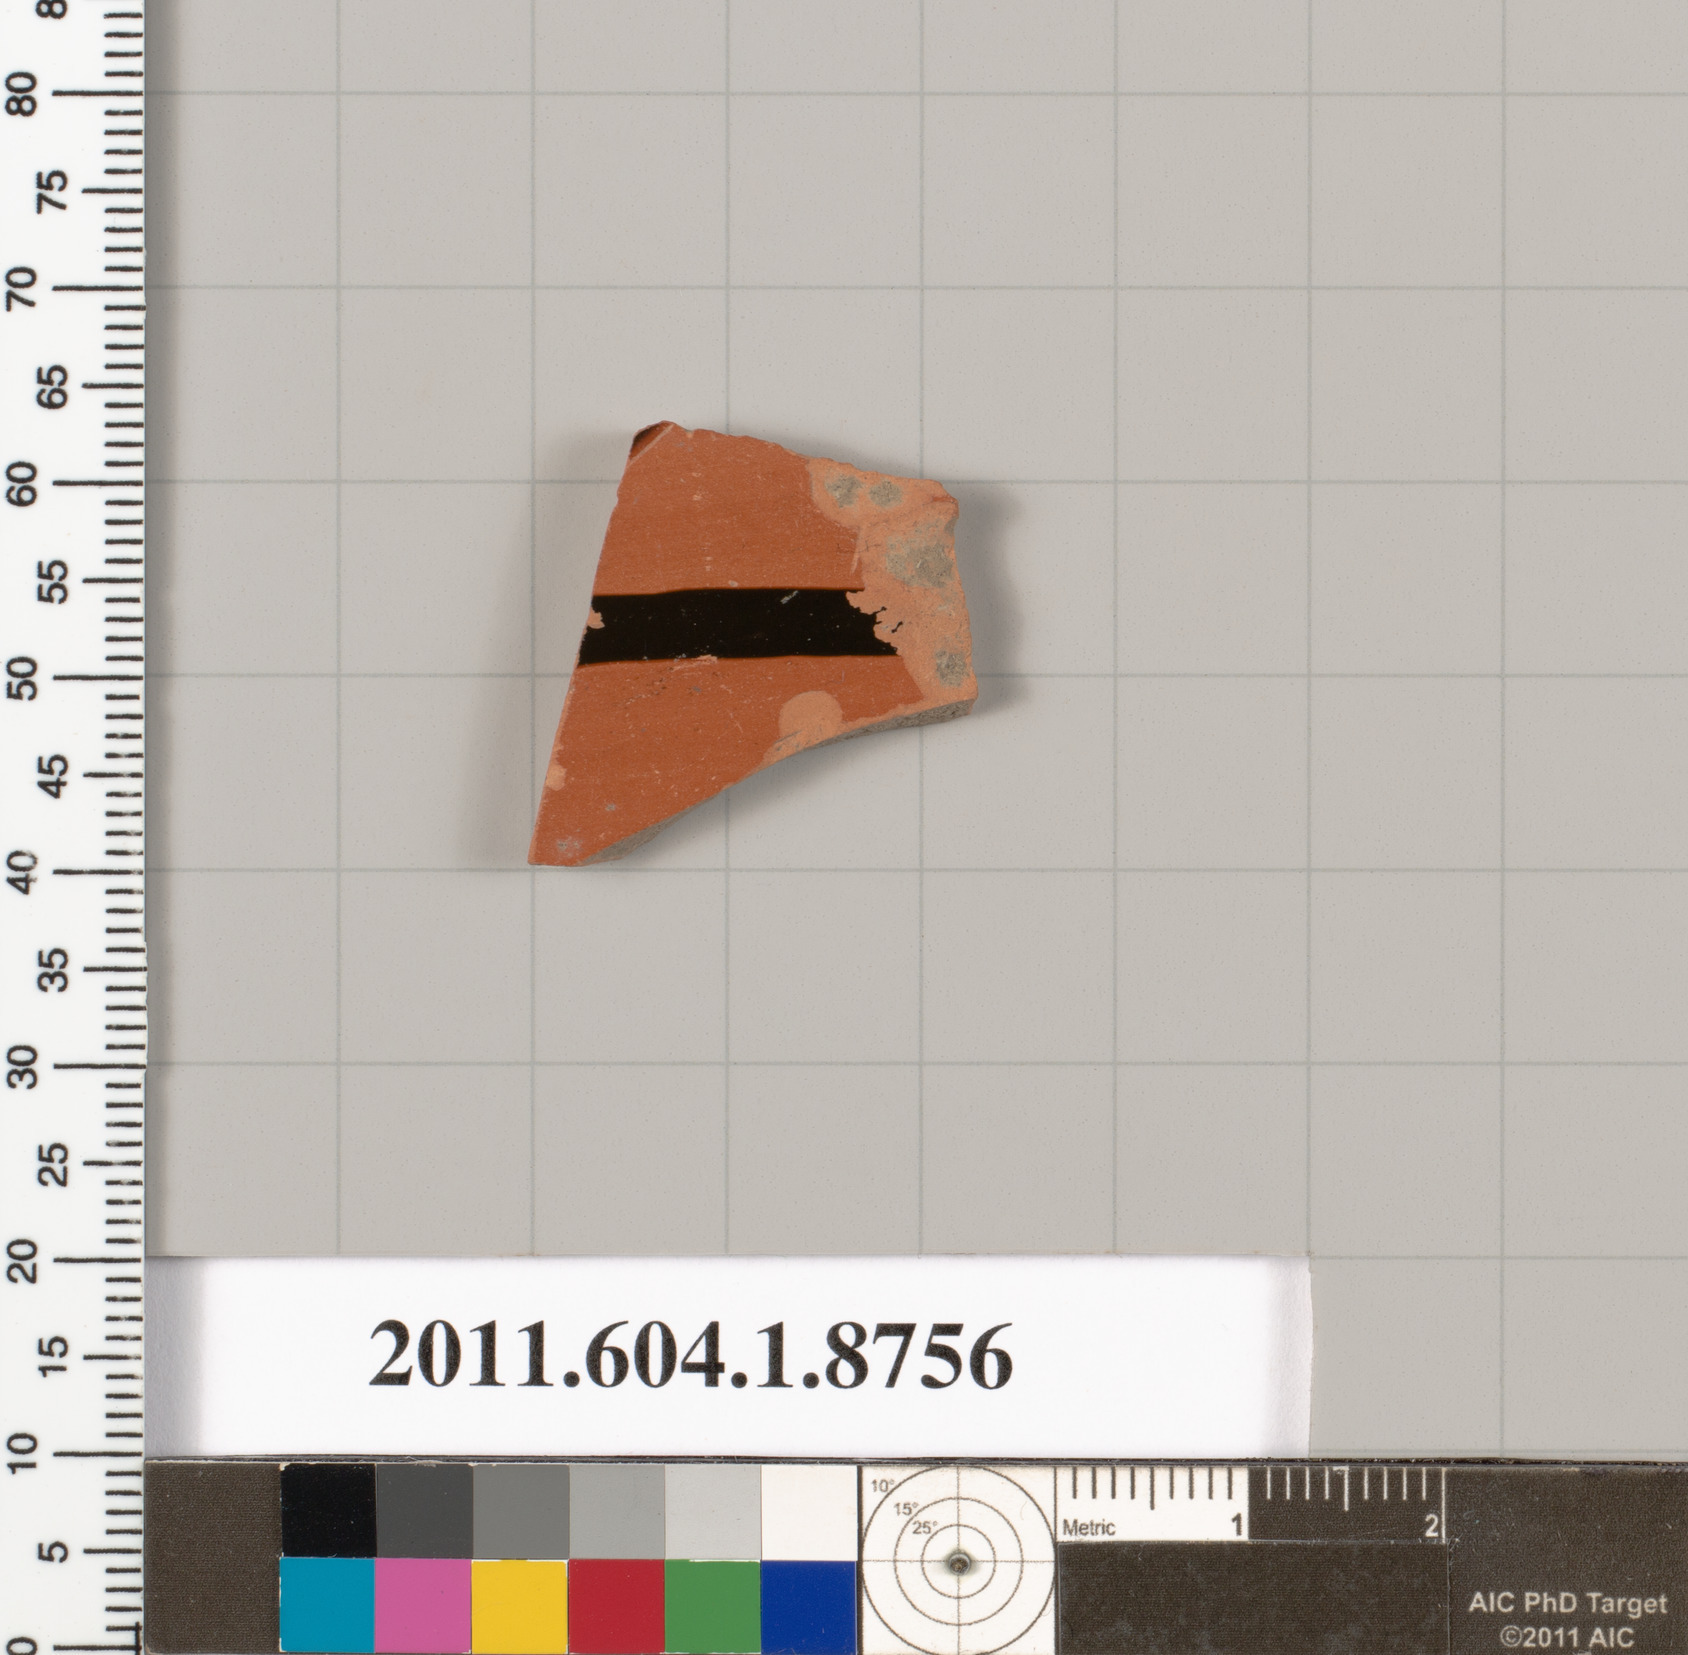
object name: kylix fragment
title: Terracotta fragment of a kylix (drinking cup)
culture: greek, attic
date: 475-451 BCE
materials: terracotta